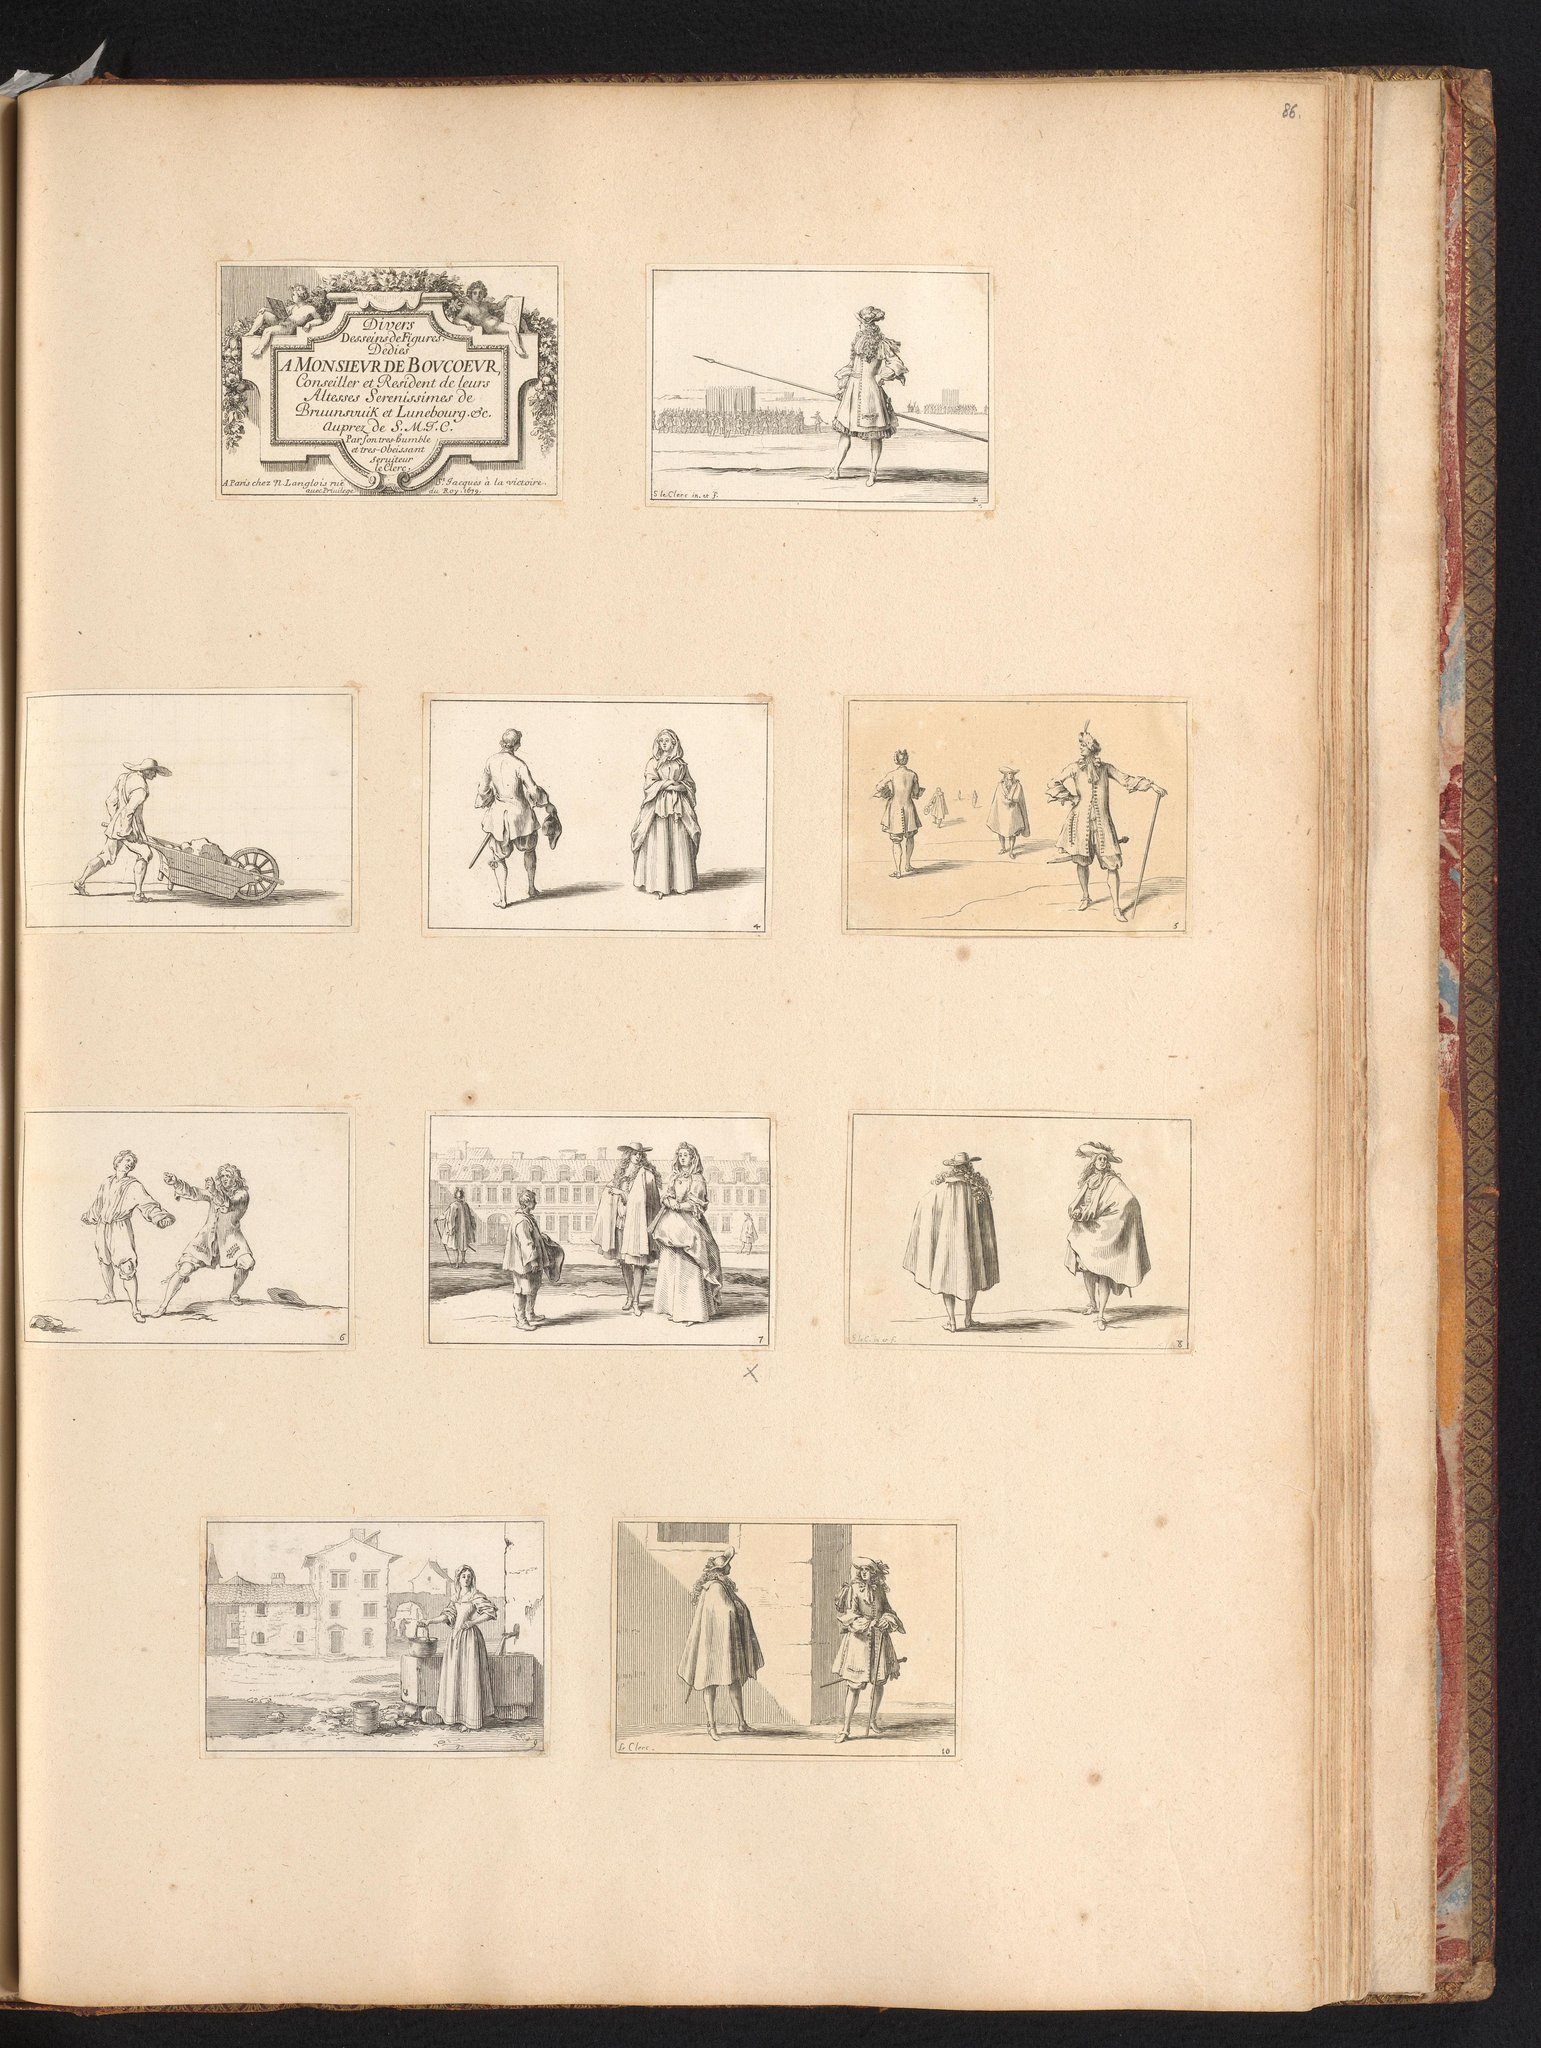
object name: album leaf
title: Tekenvoorbeelden van verschillende figuren voor Monsieur de Boucoeur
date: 1679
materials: paper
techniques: etching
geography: paris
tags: model-books ~ implements of painter, folk costume, regional costume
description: Deze titelprent en prenten maken deel uit van een 21-delige serie met tekenvoorbeelden van verschillende alledaagse figuren voor Monsieur de Boucoeur. Zoals vermeld in IFF 17e siècle zou de serie corresponderen met de serie 'Caprices' door Callot.